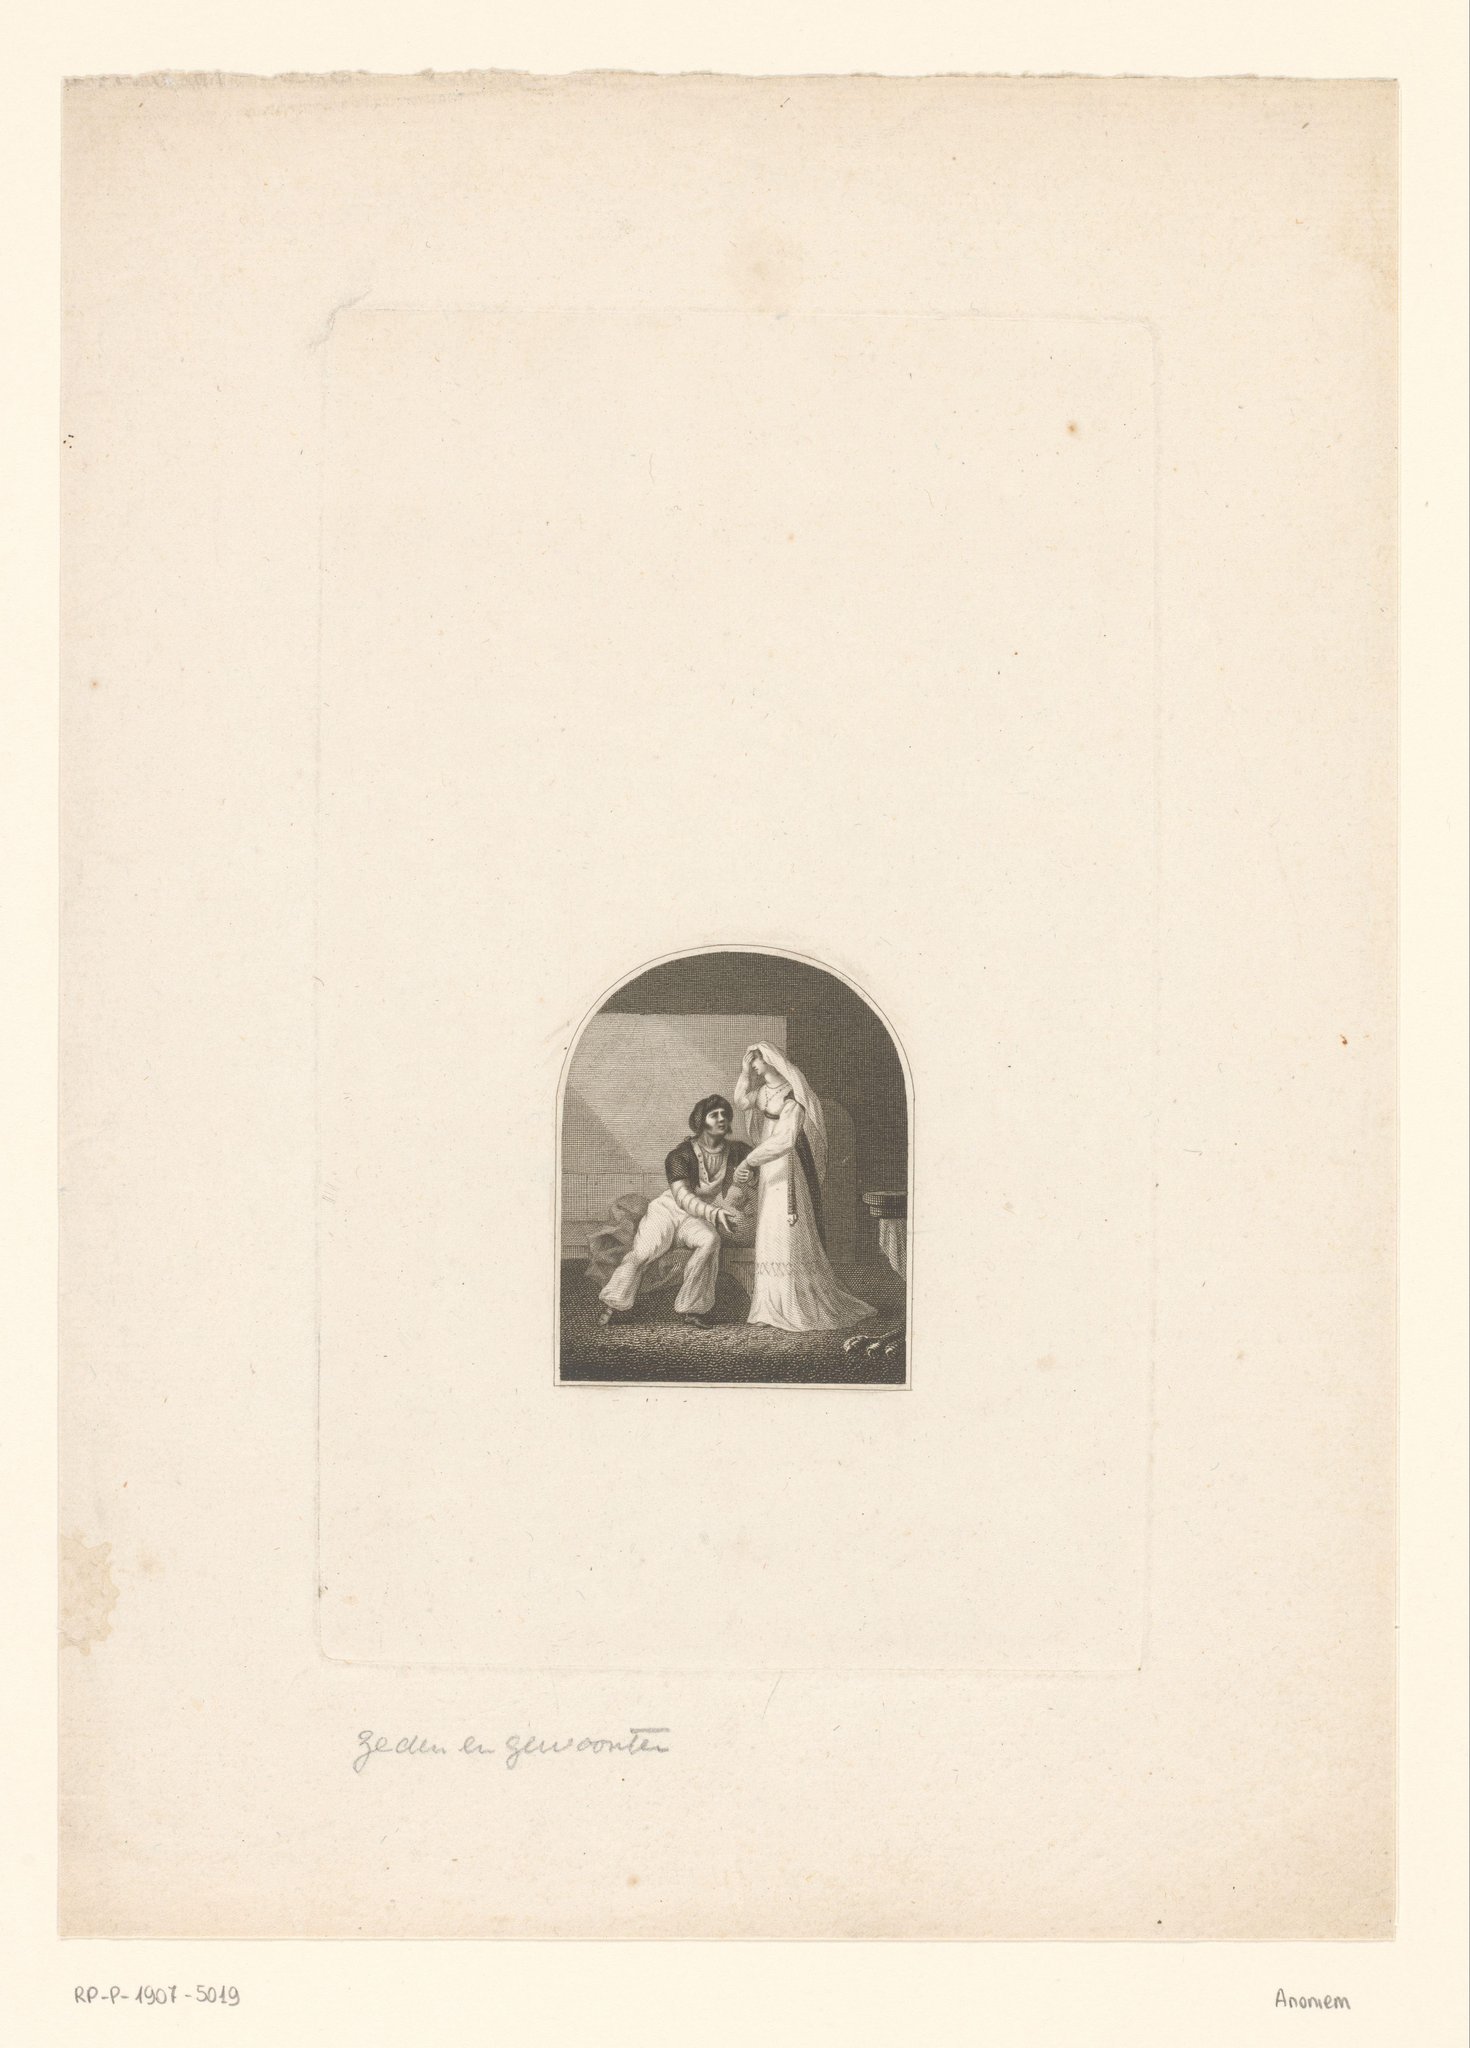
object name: print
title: Man pakt de hand van een vrouw met haar hand voor haar hoofd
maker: Anonymous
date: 1800-1880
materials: paper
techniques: etching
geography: netherlands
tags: hand(s) bent towards the head, veil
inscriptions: collector's mark: Lugt 2228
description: Een latere staat is waarschijnlijk gebruikt als boekillustratie.